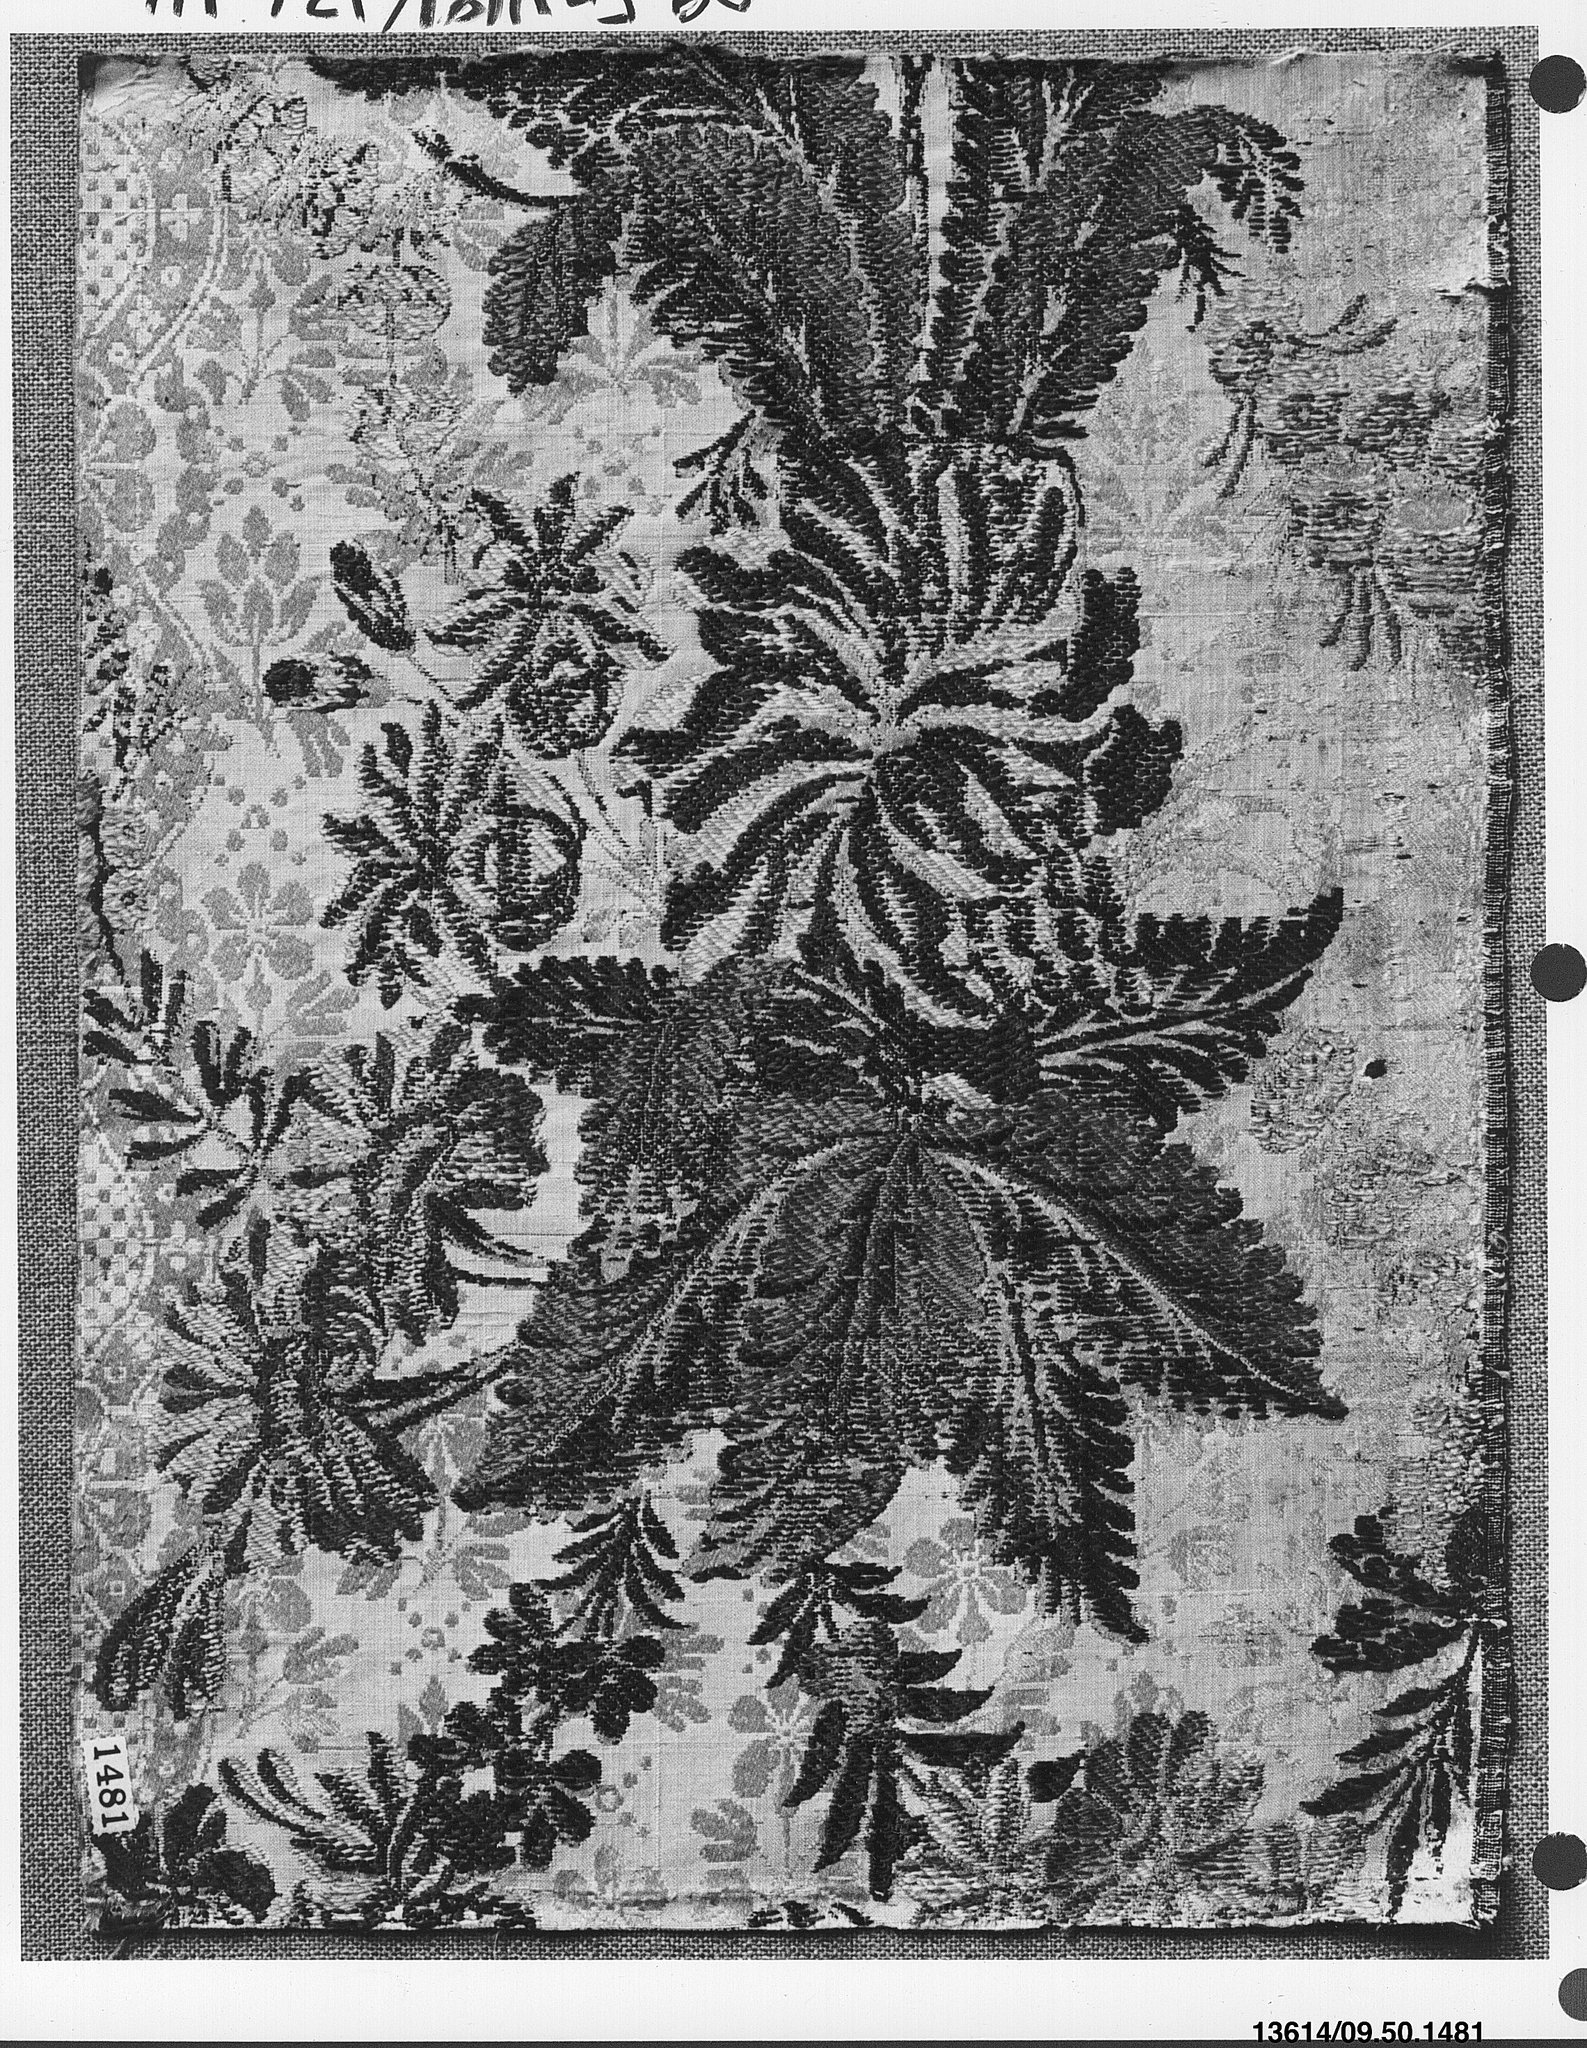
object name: piece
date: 1701-1733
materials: silk